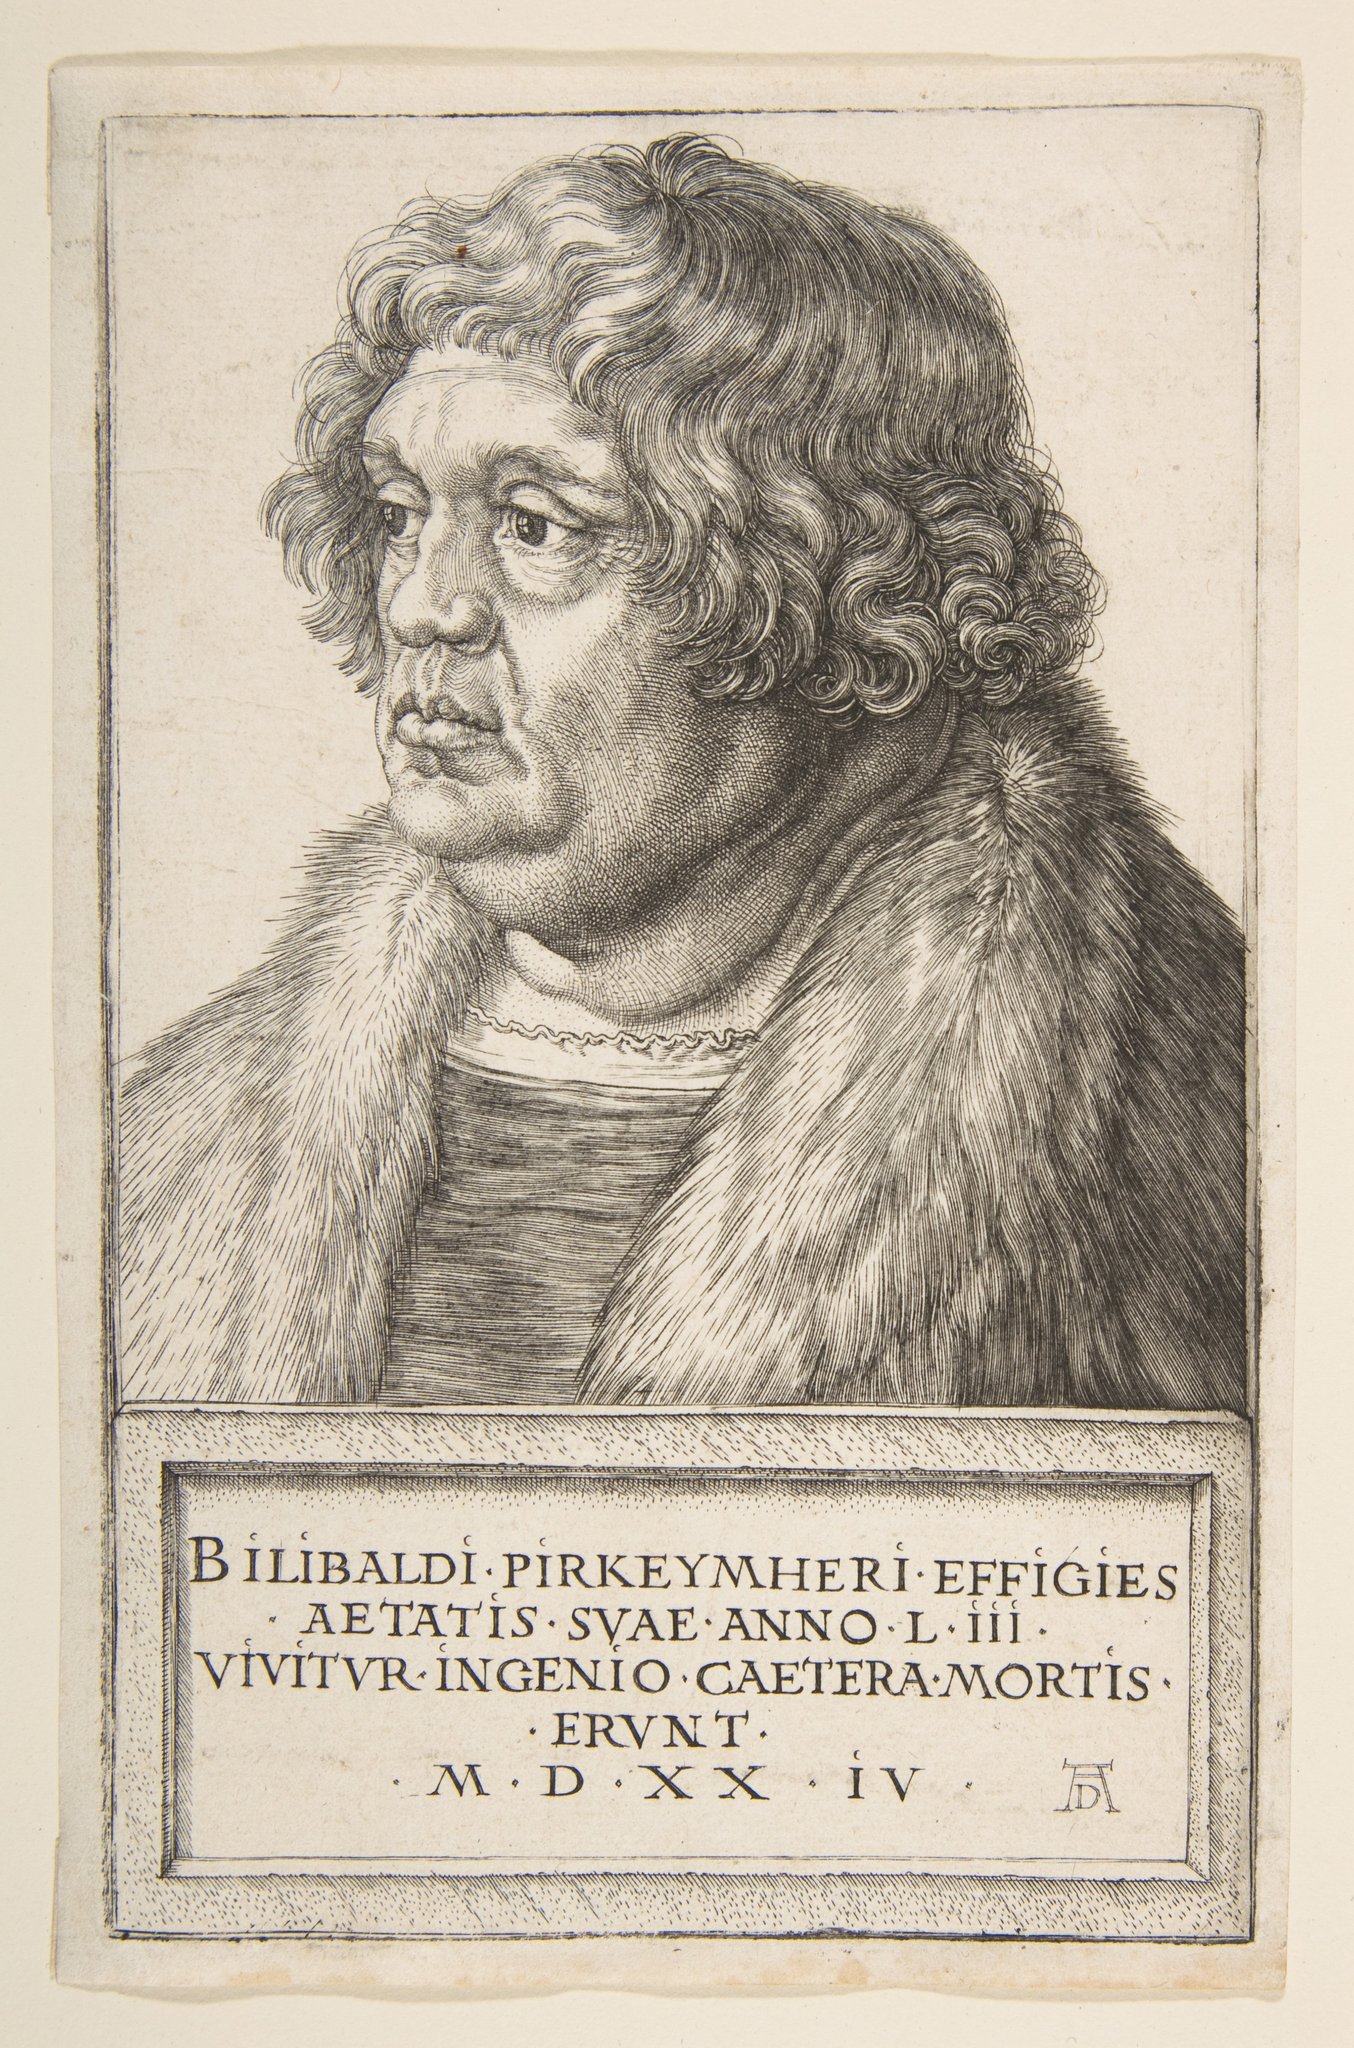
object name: print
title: Willibald Pirckheimer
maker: albrecht dürer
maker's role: artist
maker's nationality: german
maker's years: 1471-1528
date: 1524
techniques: engraving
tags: men,portraits